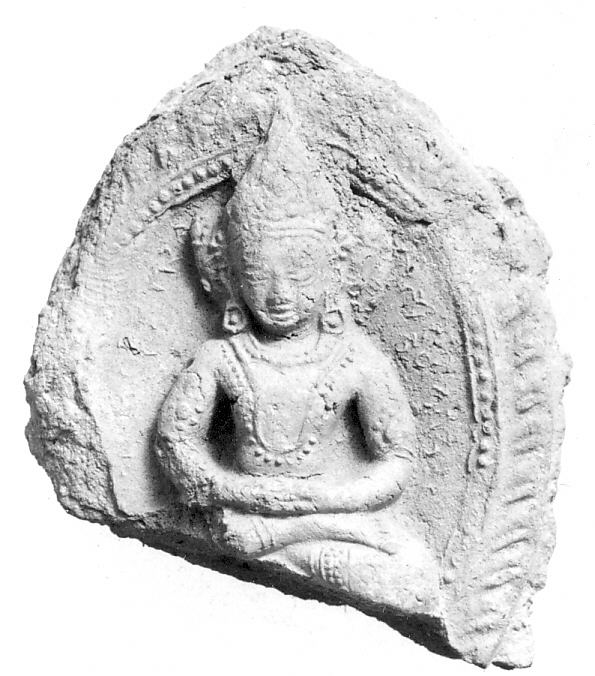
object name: plaque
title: Votive Plaque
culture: central asian or tibetan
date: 901-1600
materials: clay